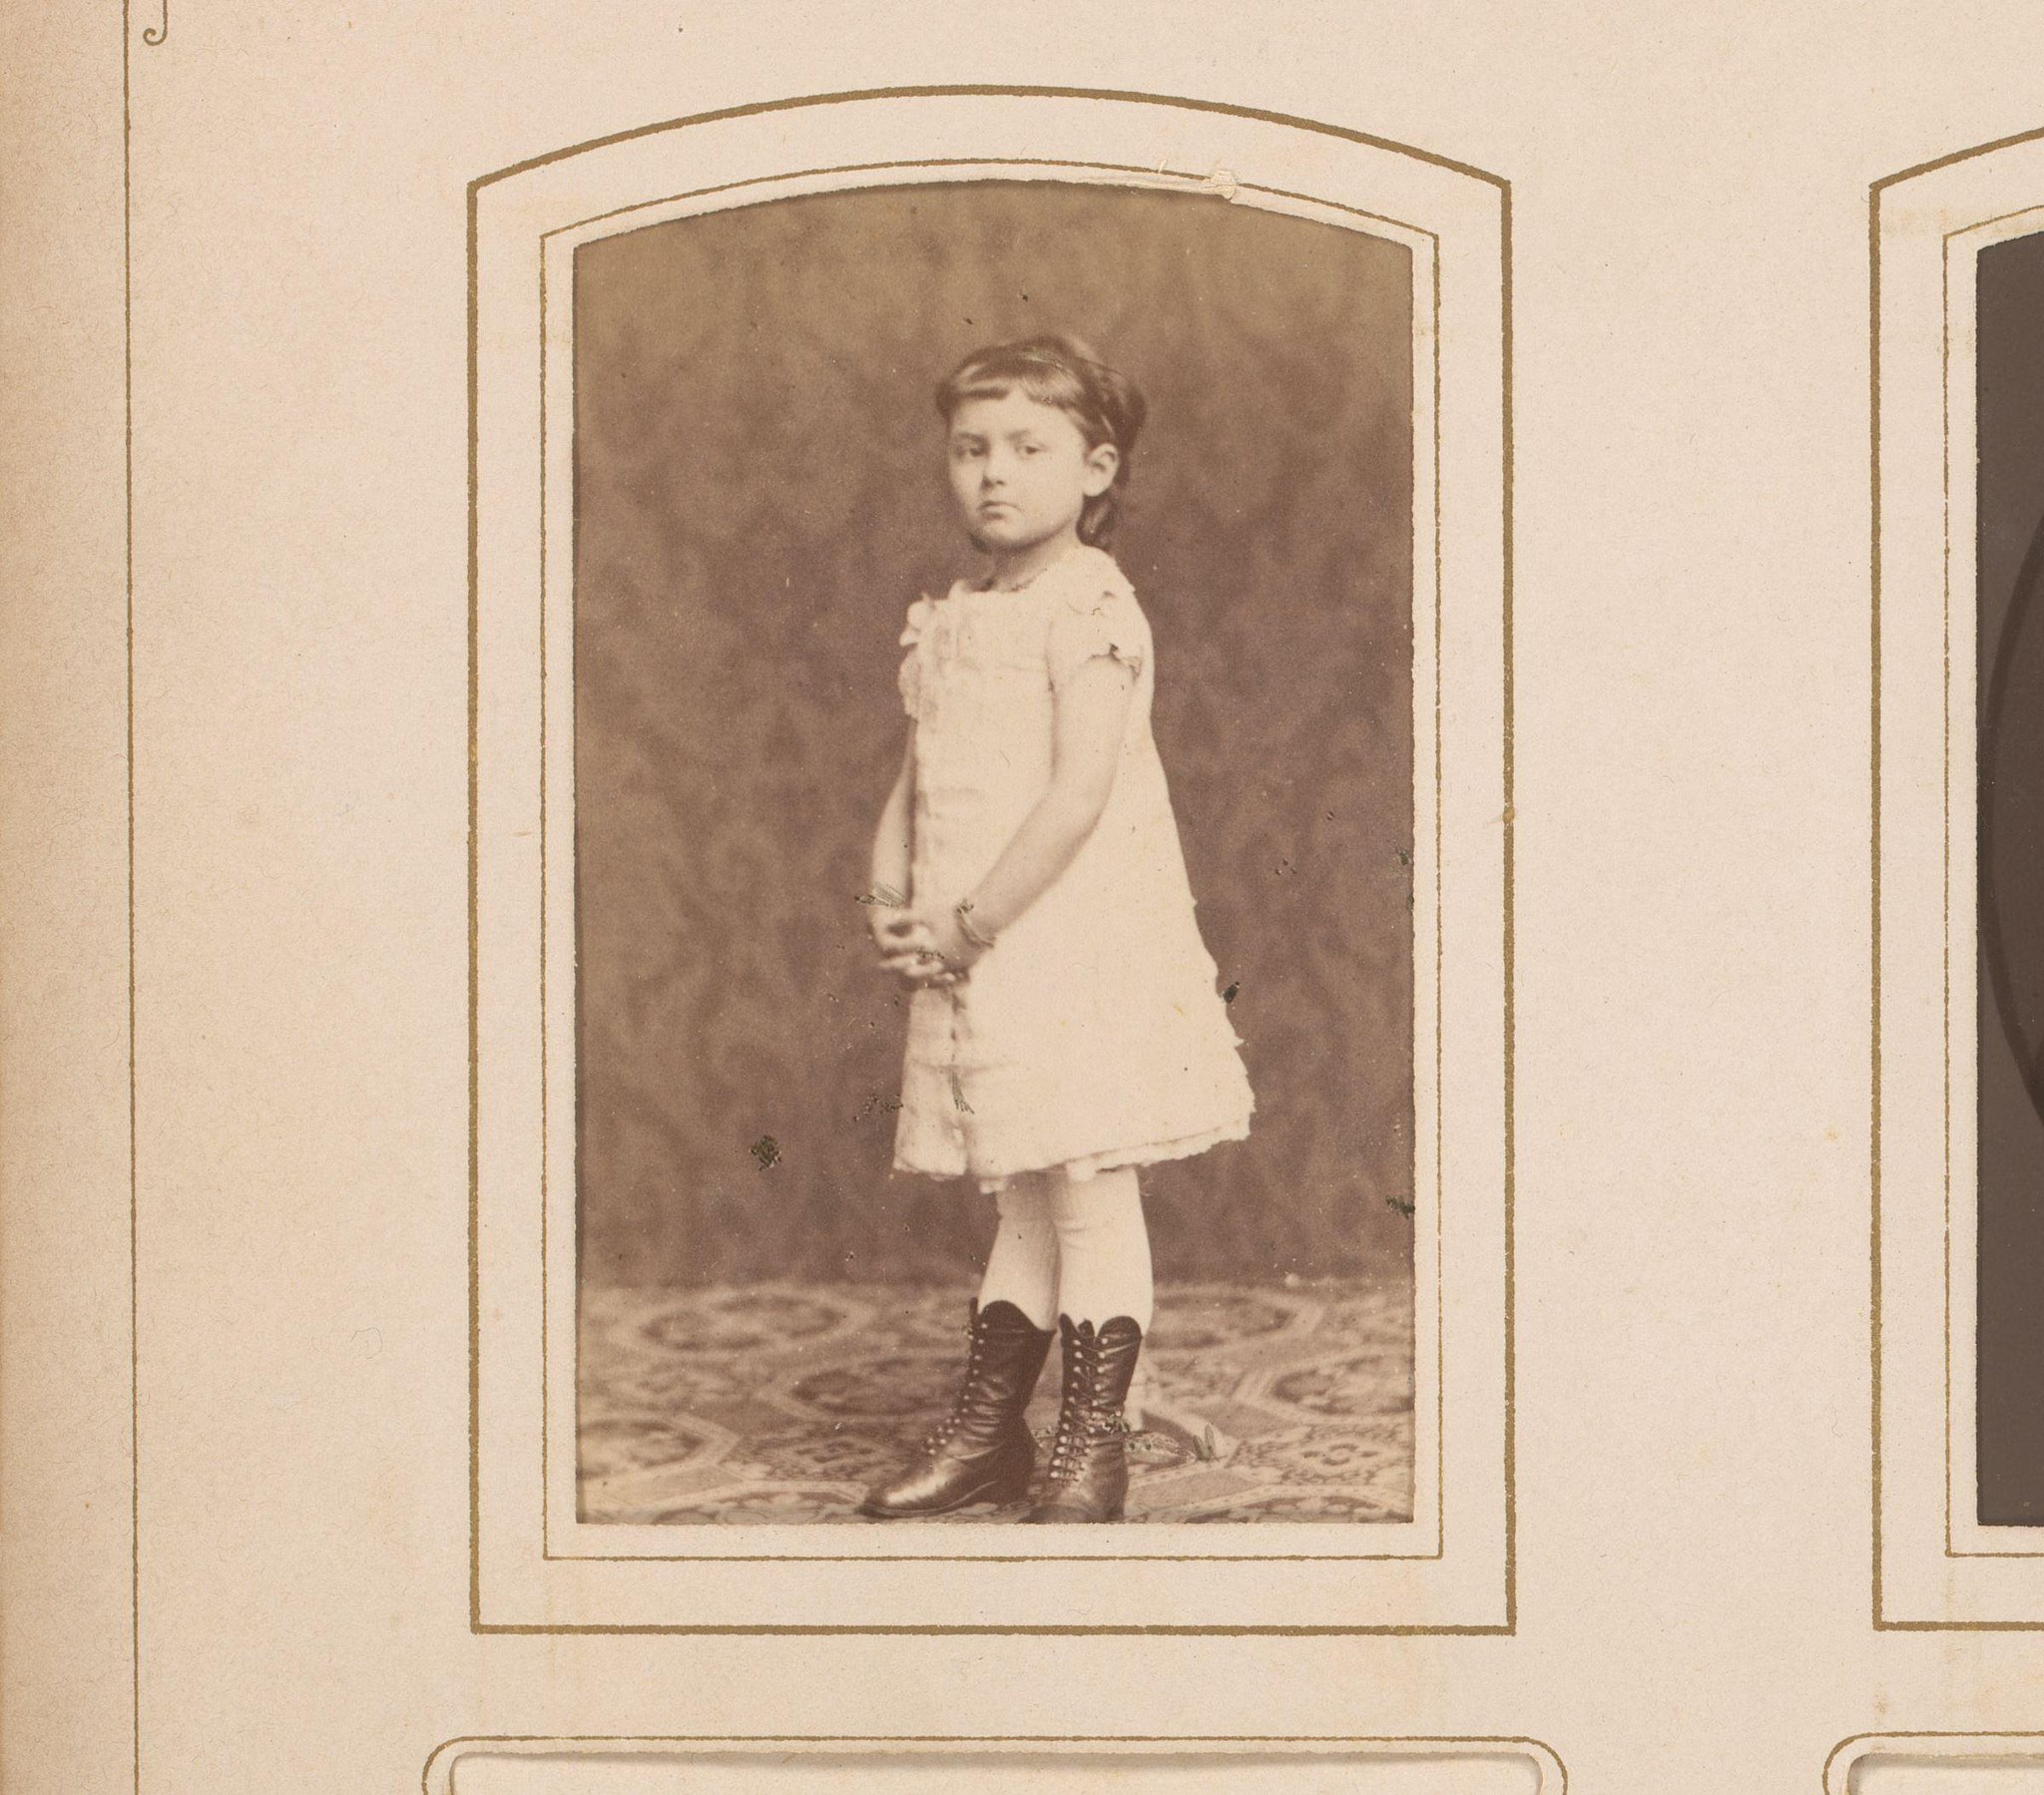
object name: carte de visite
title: Portret van een staand meisje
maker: johan hendrik hoffmeister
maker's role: print maker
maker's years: 1823-1904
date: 1877-1883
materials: cardboard, photographic support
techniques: albumen print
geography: the hague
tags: historical persons - bb - woman, girl (child between toddler and youth), standing figure - aa - female human figure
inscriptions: inscription: ‘Photographie/ van/ J. H. Hoffmeister./ 's Gravenhage/ 1.Anna Polownastraat 1./ Specialiteit in Vergrootingen’